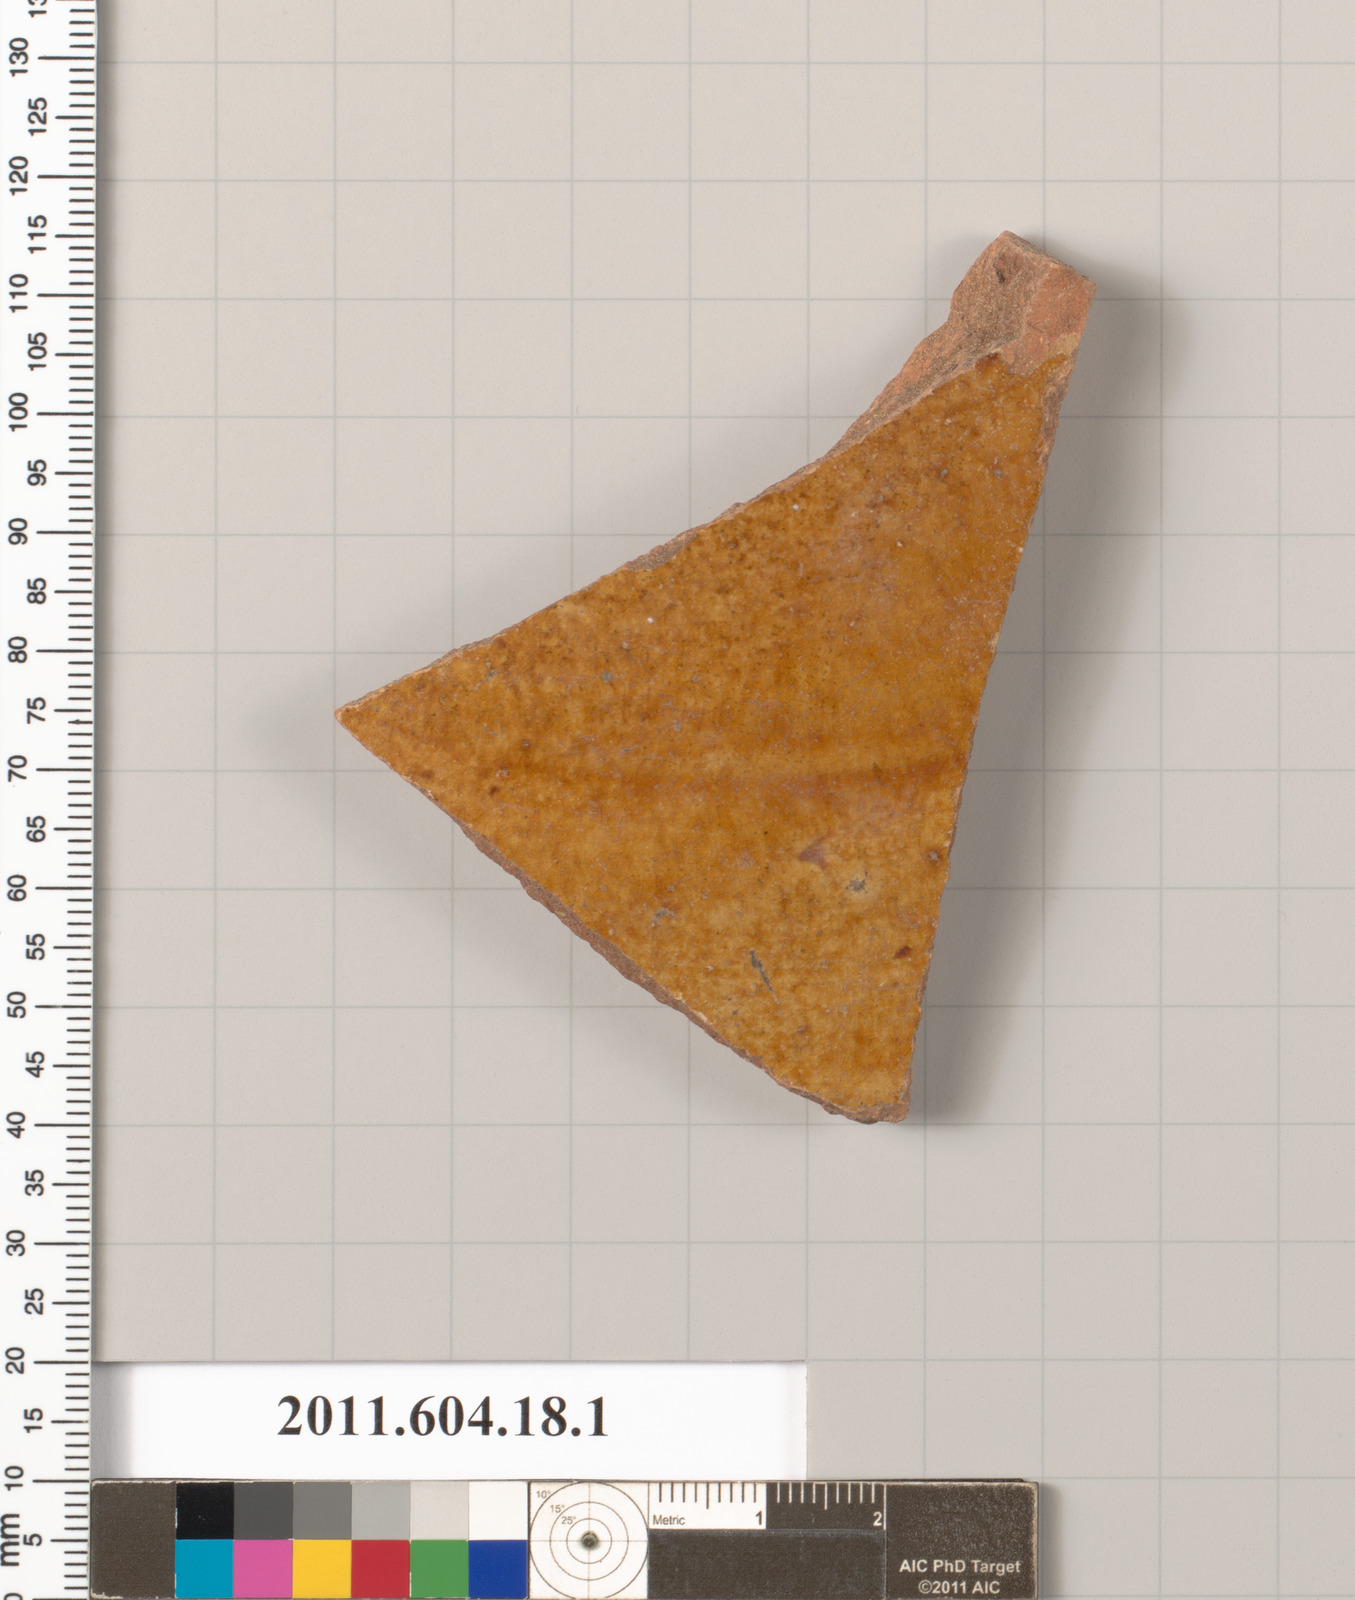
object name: plate or bowl fragment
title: Fragment of a glazed ceramic plate or bowl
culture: byzantine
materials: earthenware, glaze